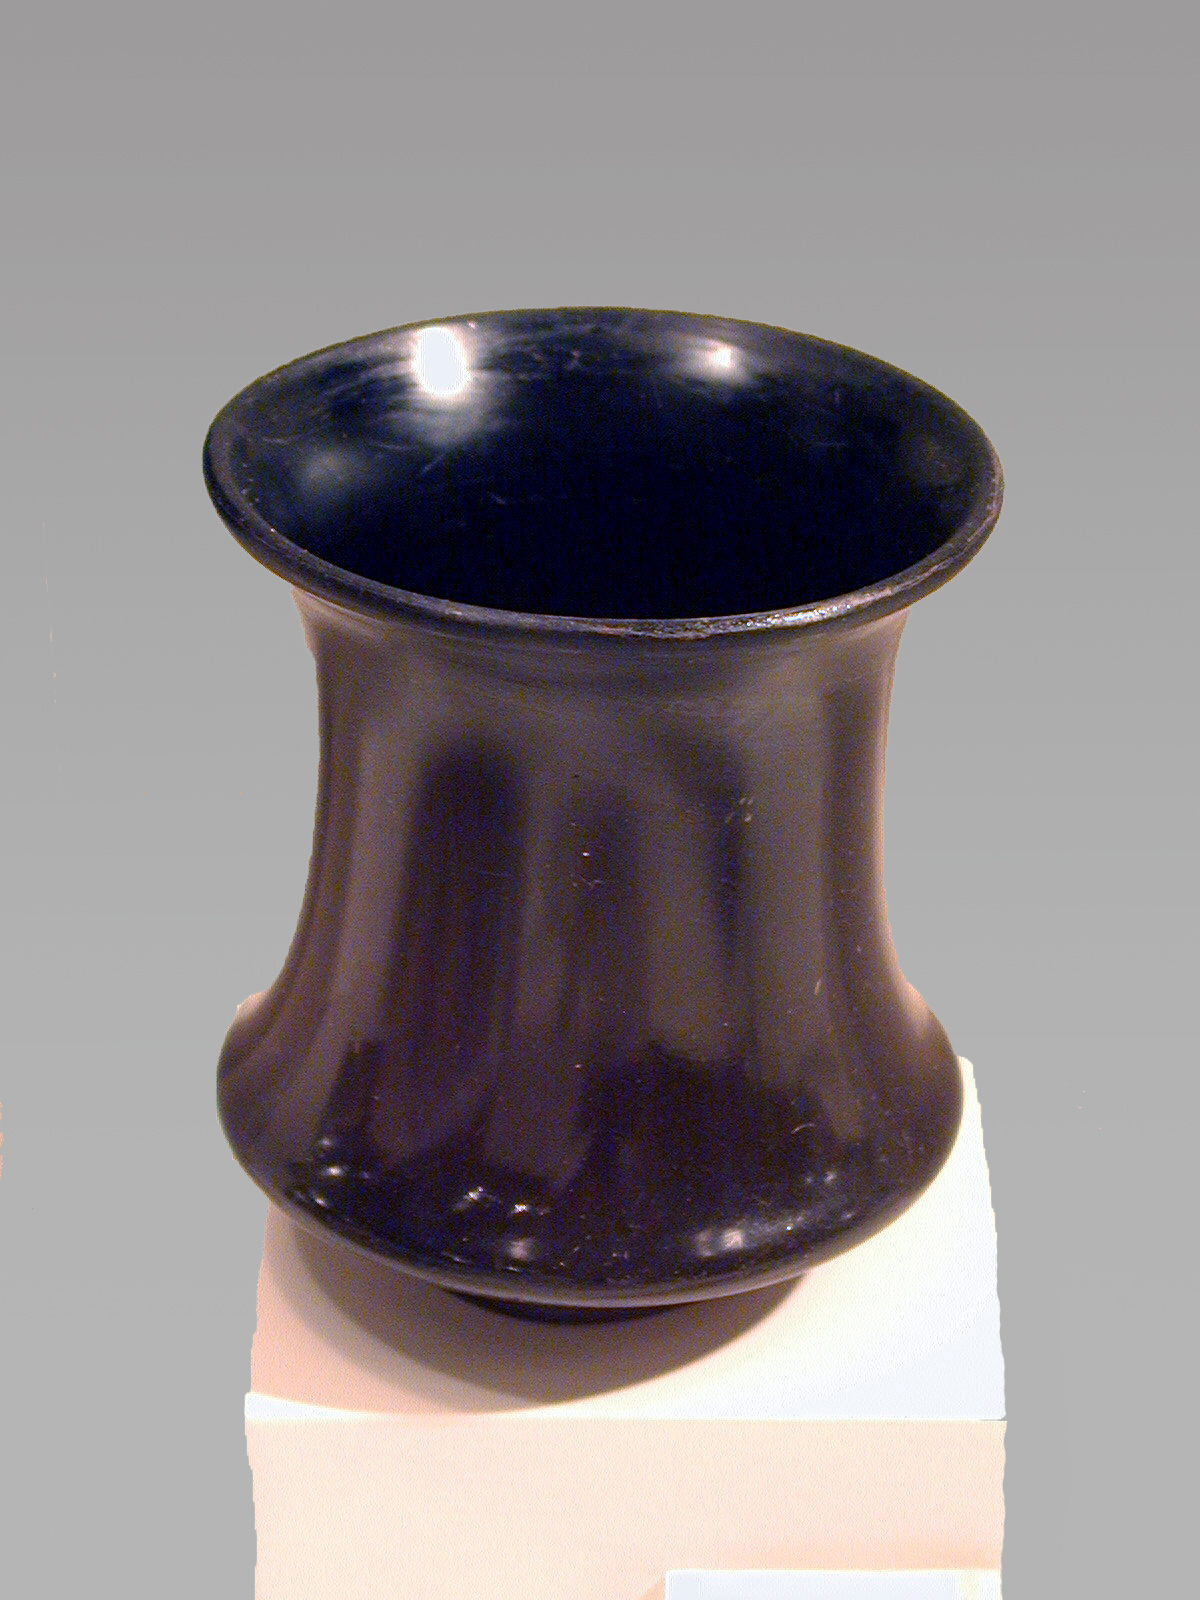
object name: beaker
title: Glass beaker (carchesium)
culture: roman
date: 167-266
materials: glass